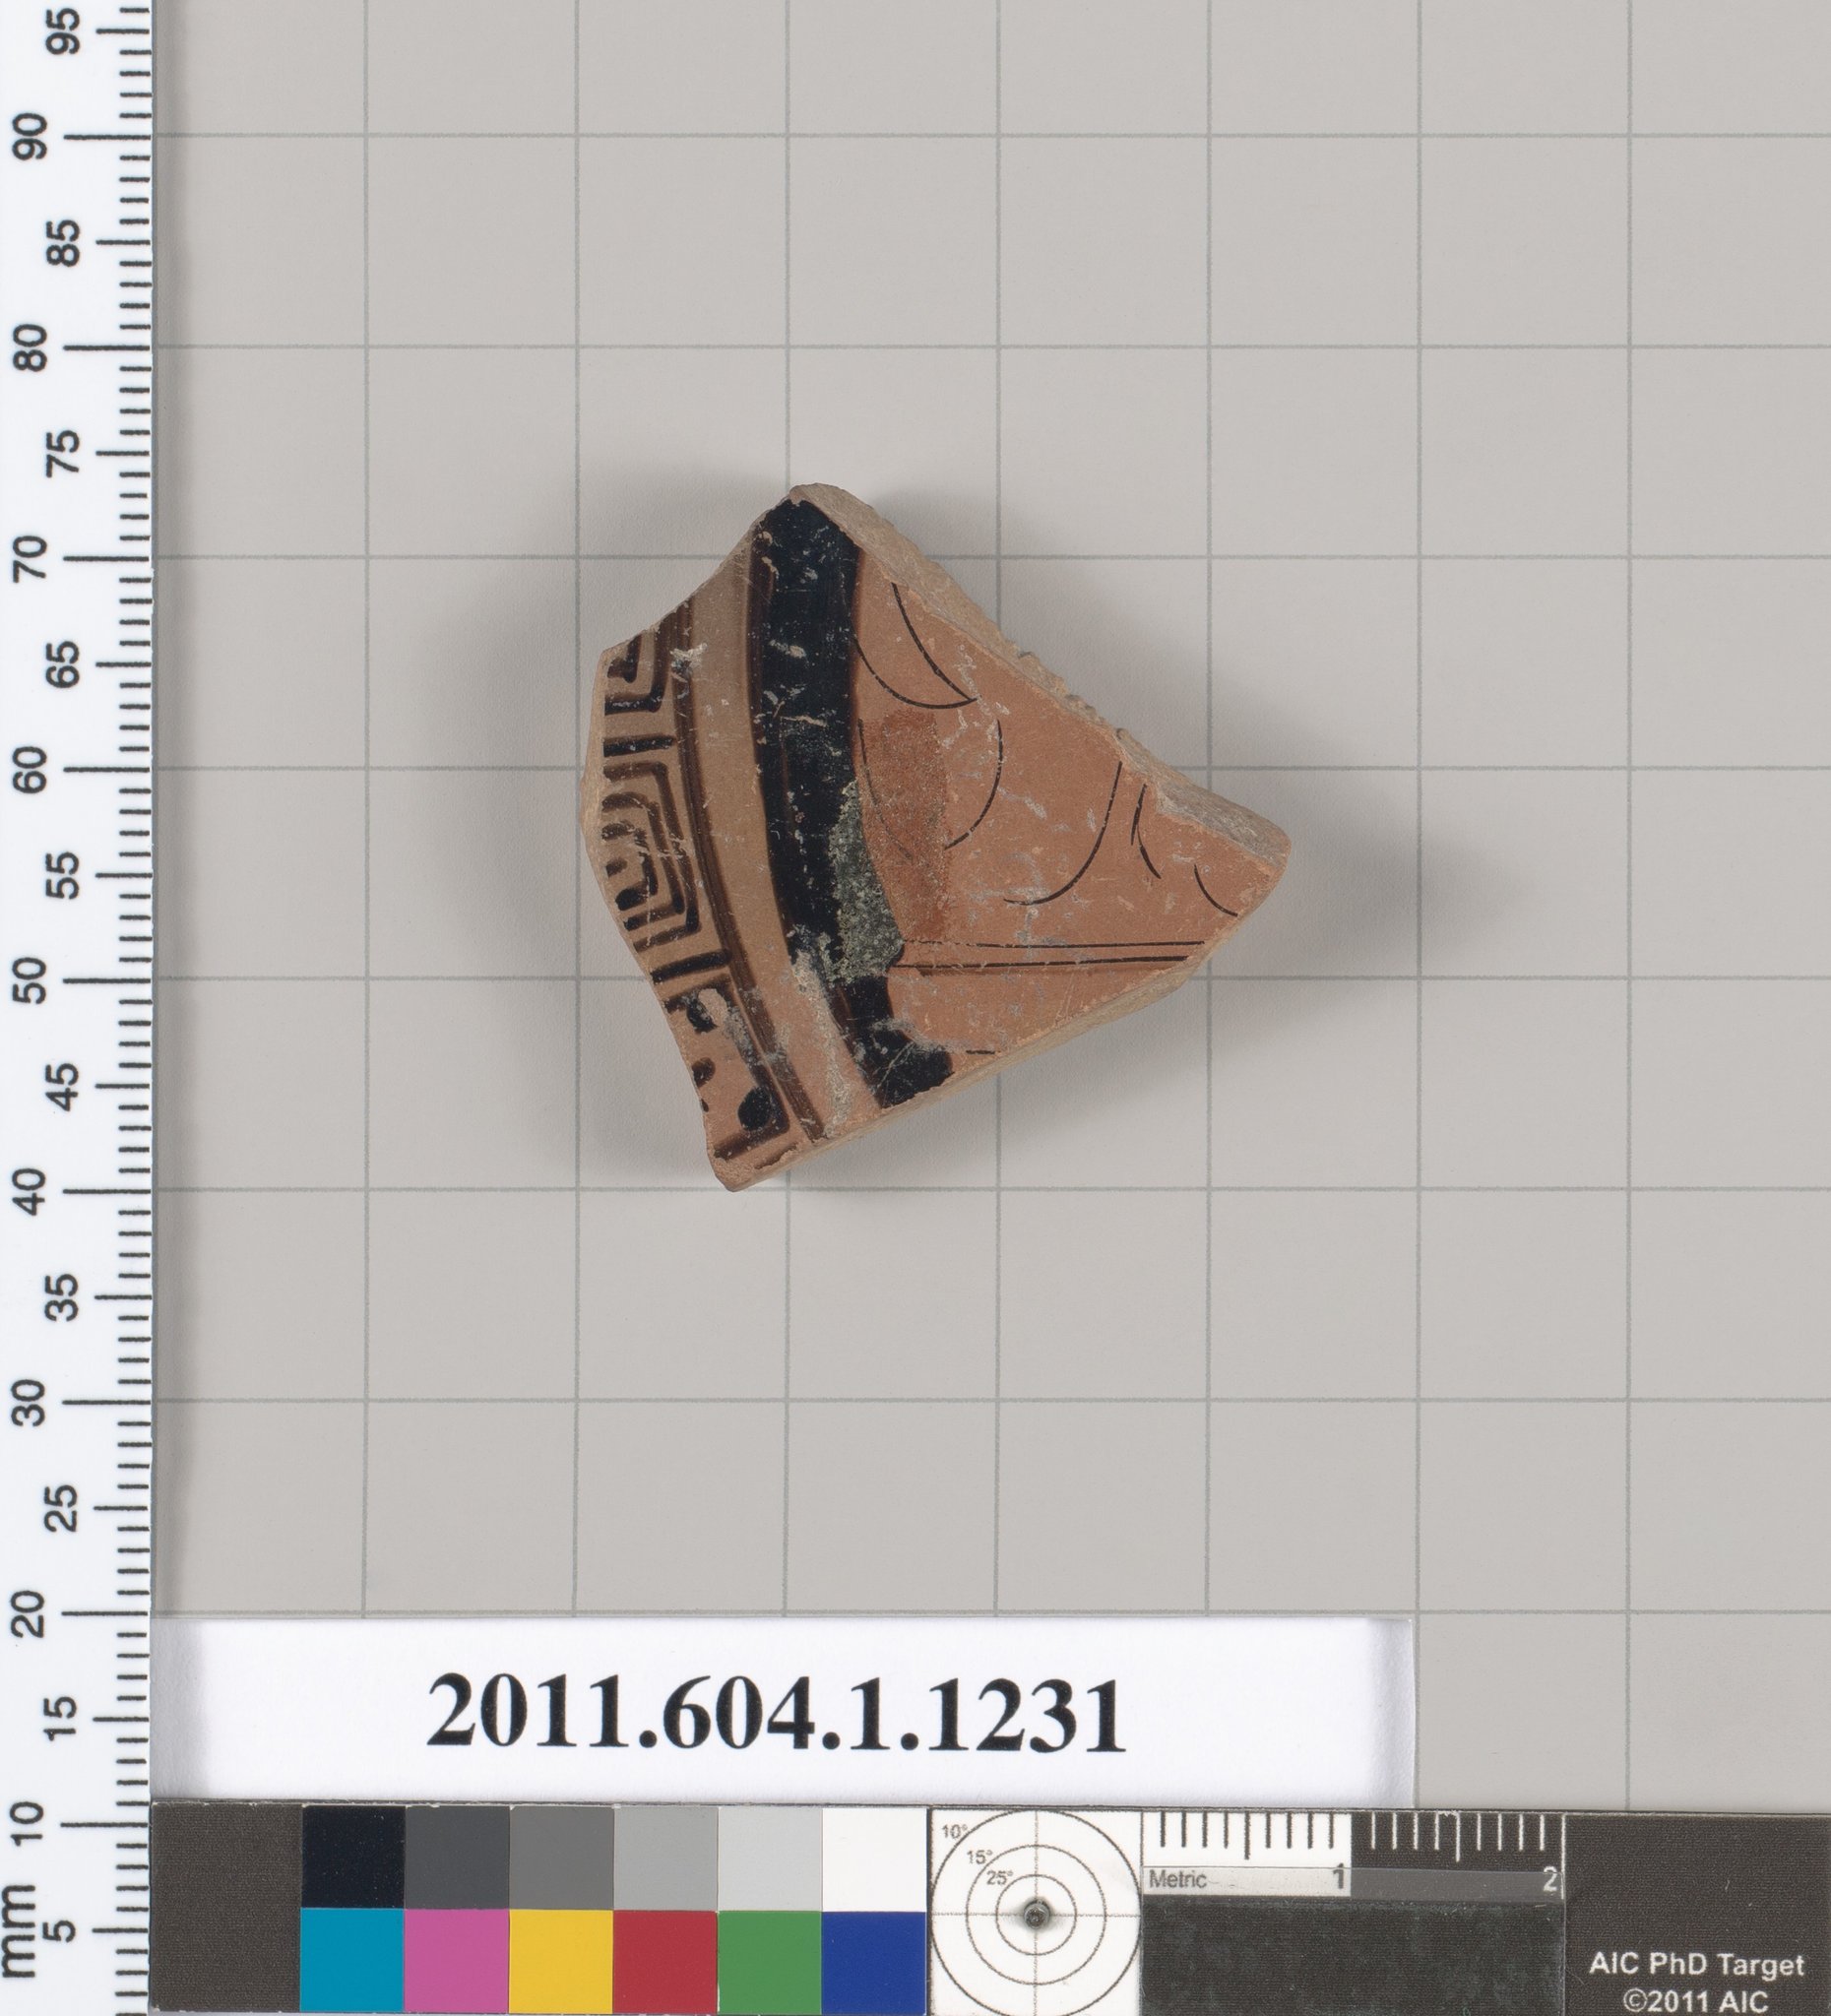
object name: kylix fragment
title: Terracotta fragment of a kylix (drinking cup)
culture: greek, attic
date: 467-435 BCE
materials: terracotta